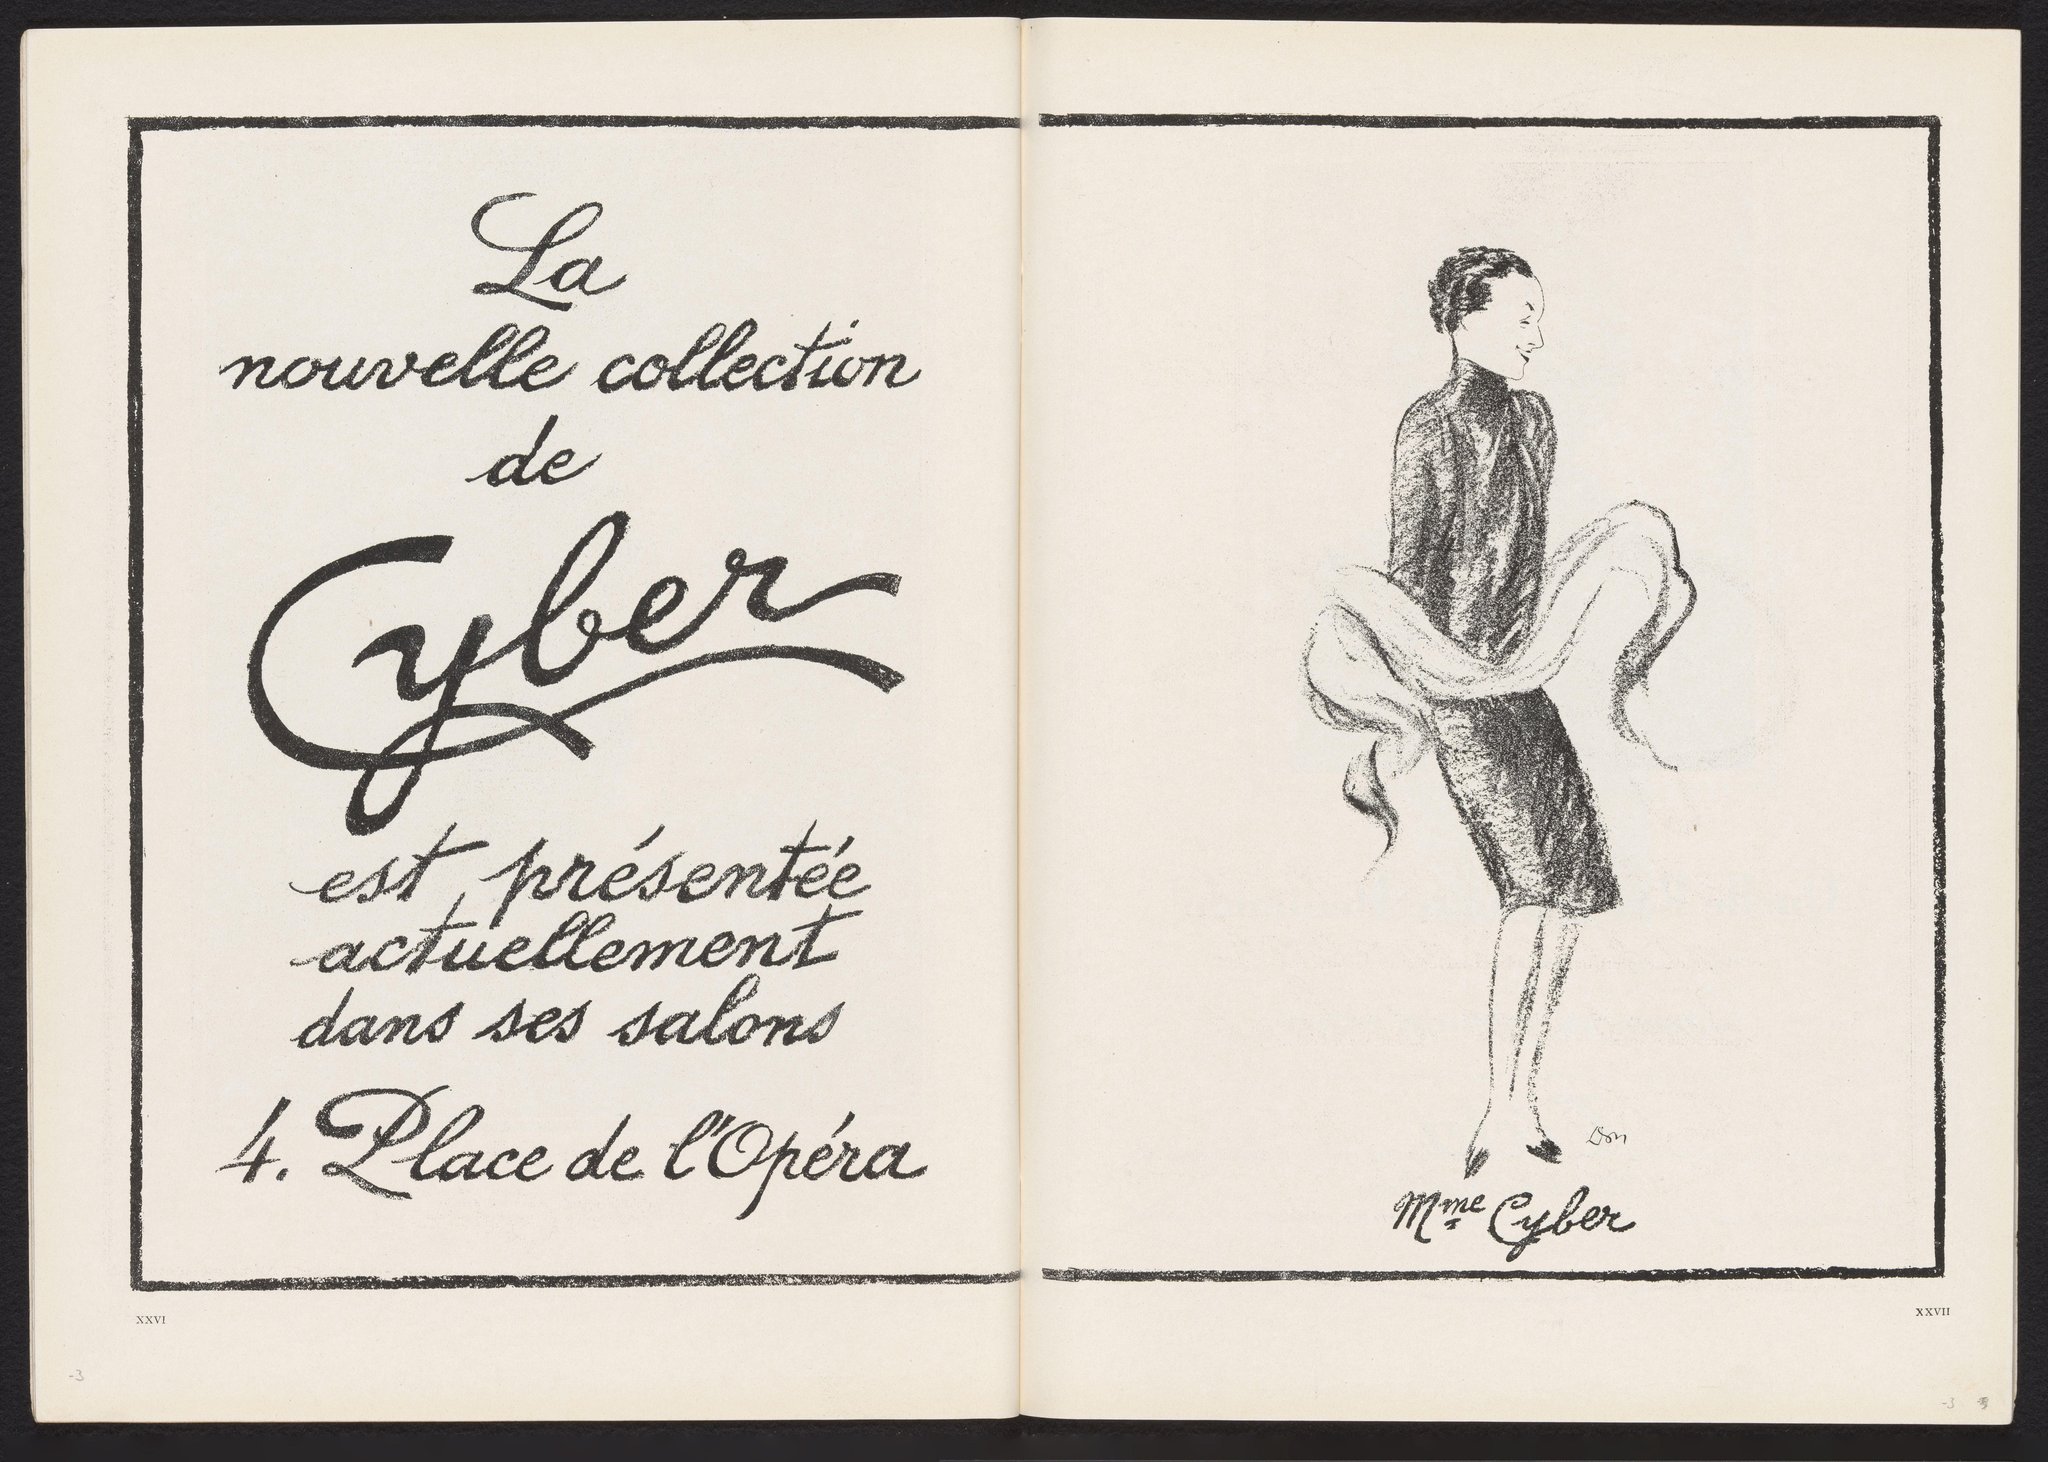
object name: fashion print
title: Femina, Mars 1928: pagina's XXVI en XXVII: dubbele pagina met advertentie voor 'la nouvelle collection de Cyber"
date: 1928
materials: paper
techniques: photography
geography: paris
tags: fashion plates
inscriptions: title: ‘FEMINA Un regard indiscrèt sur les modes de printemps’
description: Modetijdschrift Femina. Mars 1928, pagina's XXVI en XXVII: dubbele pagina met advertentie voor 'la nouvelle collection de Cyber". Rechts een getekende vrouwefiguur met sjaal in de hand: Mme Cyber